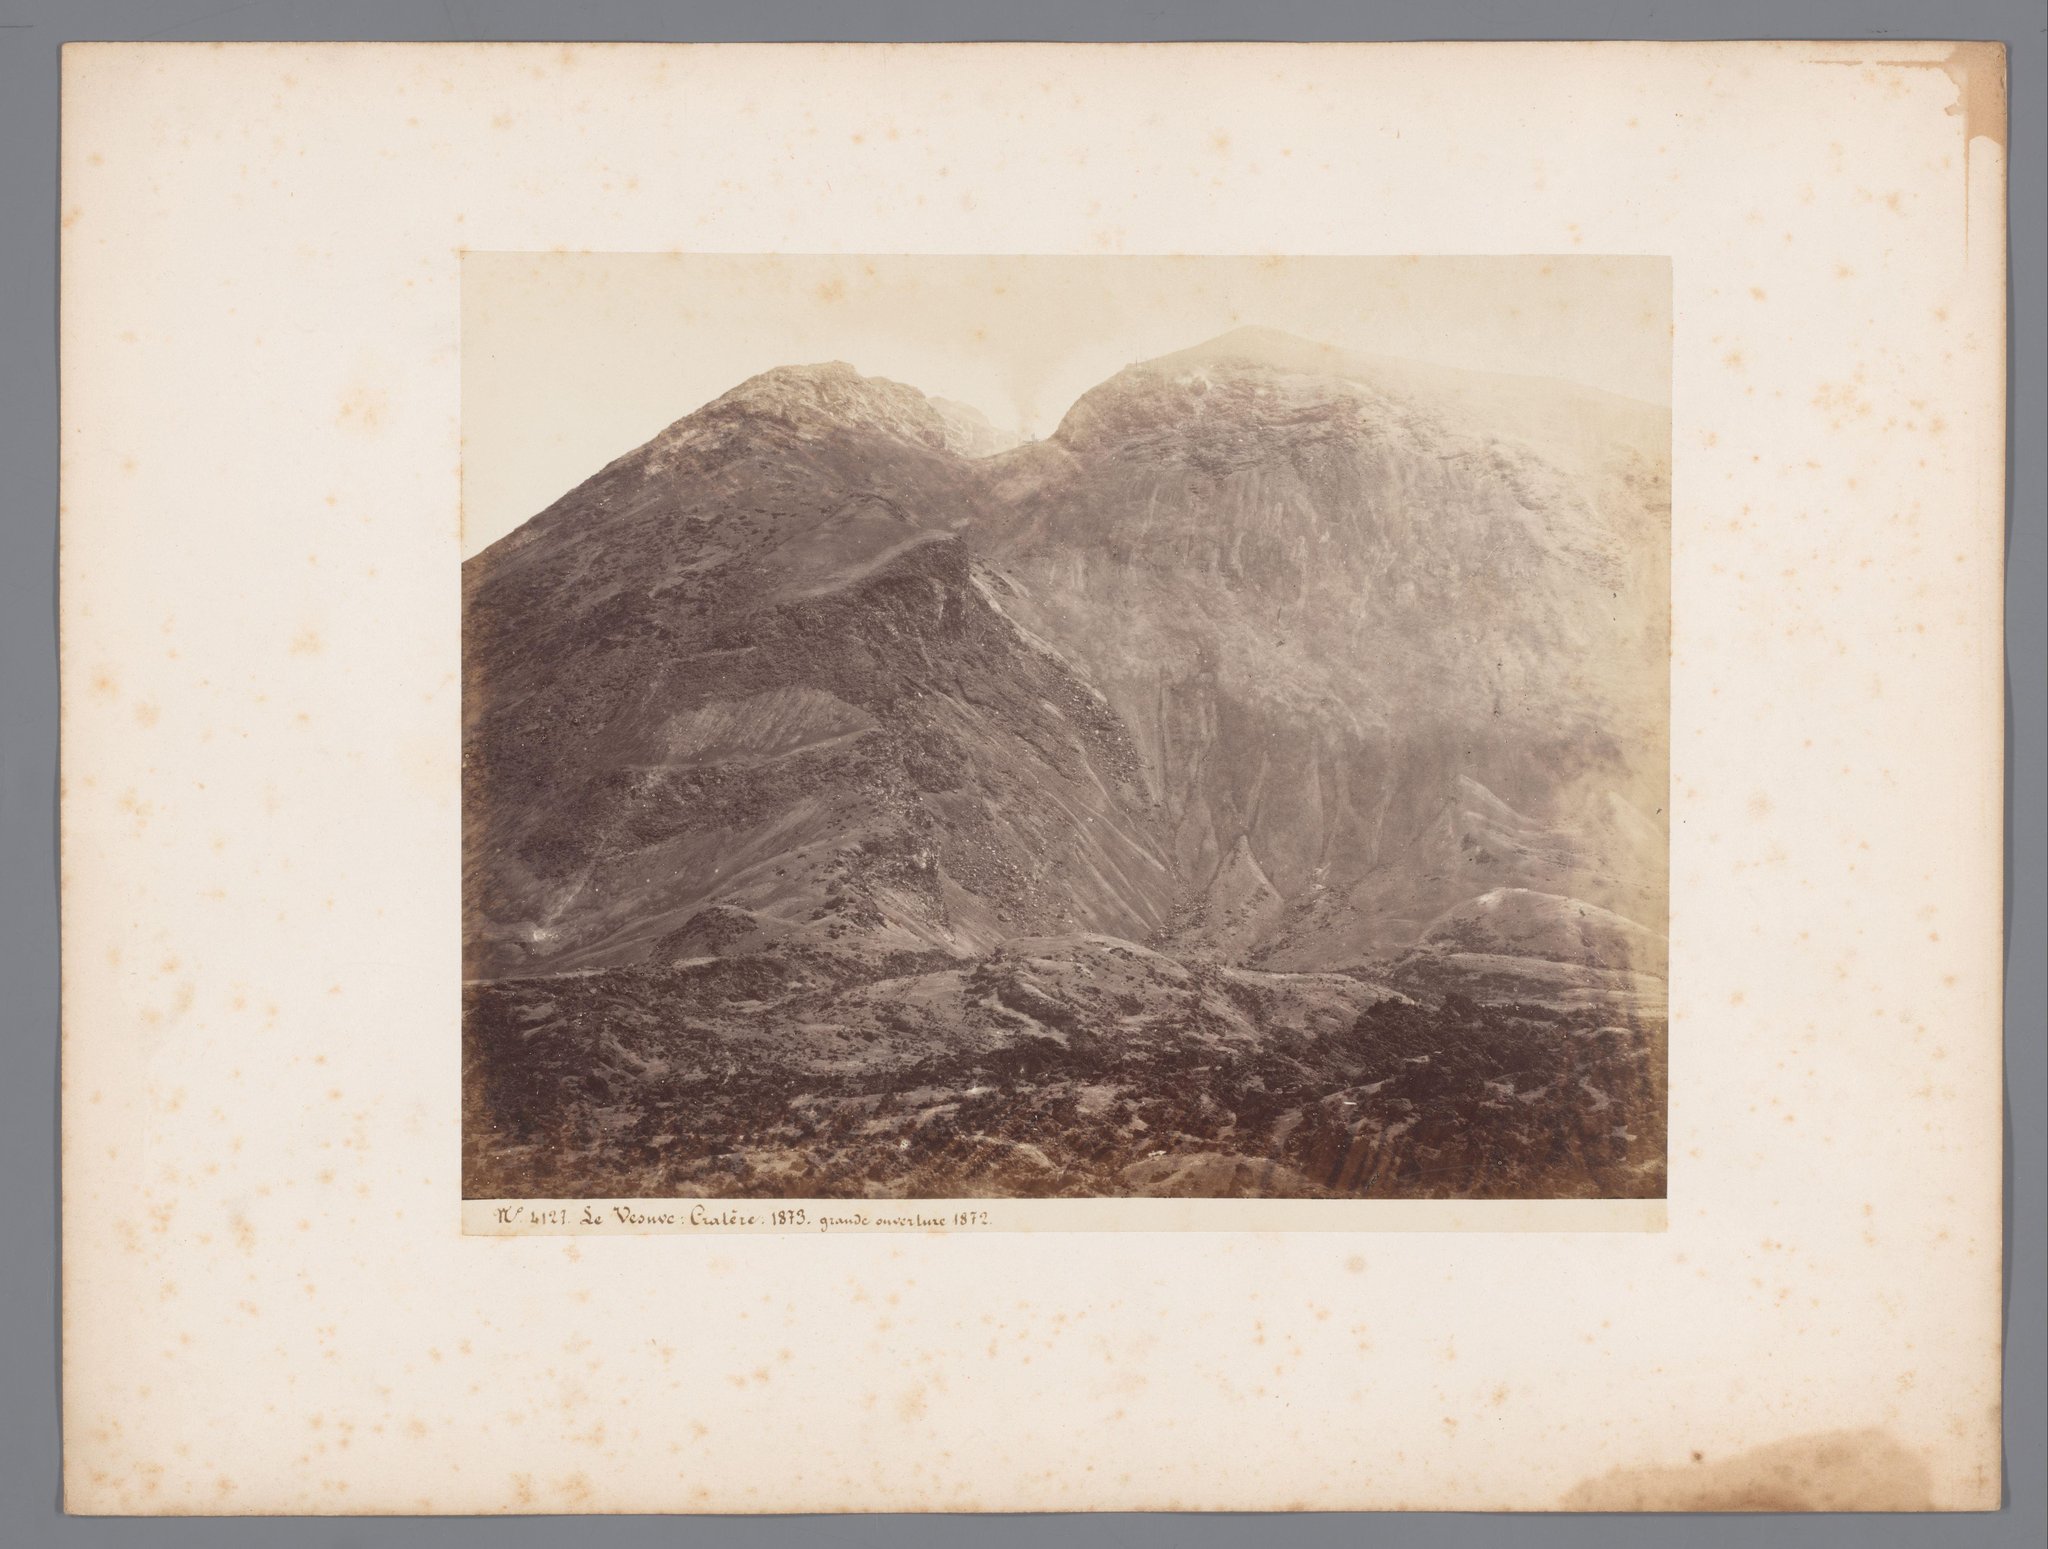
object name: photograph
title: Gezicht op de krater van de Vesuvius na de erruptie van 1872, Italië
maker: giorgio sommer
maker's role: fotograaf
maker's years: 1834-1914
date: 1873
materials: cardboard, paper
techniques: albumen print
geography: naples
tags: volcano, mount vesuvius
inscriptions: number: ‘11’, number: ‘No 4127’, number: ‘92.’